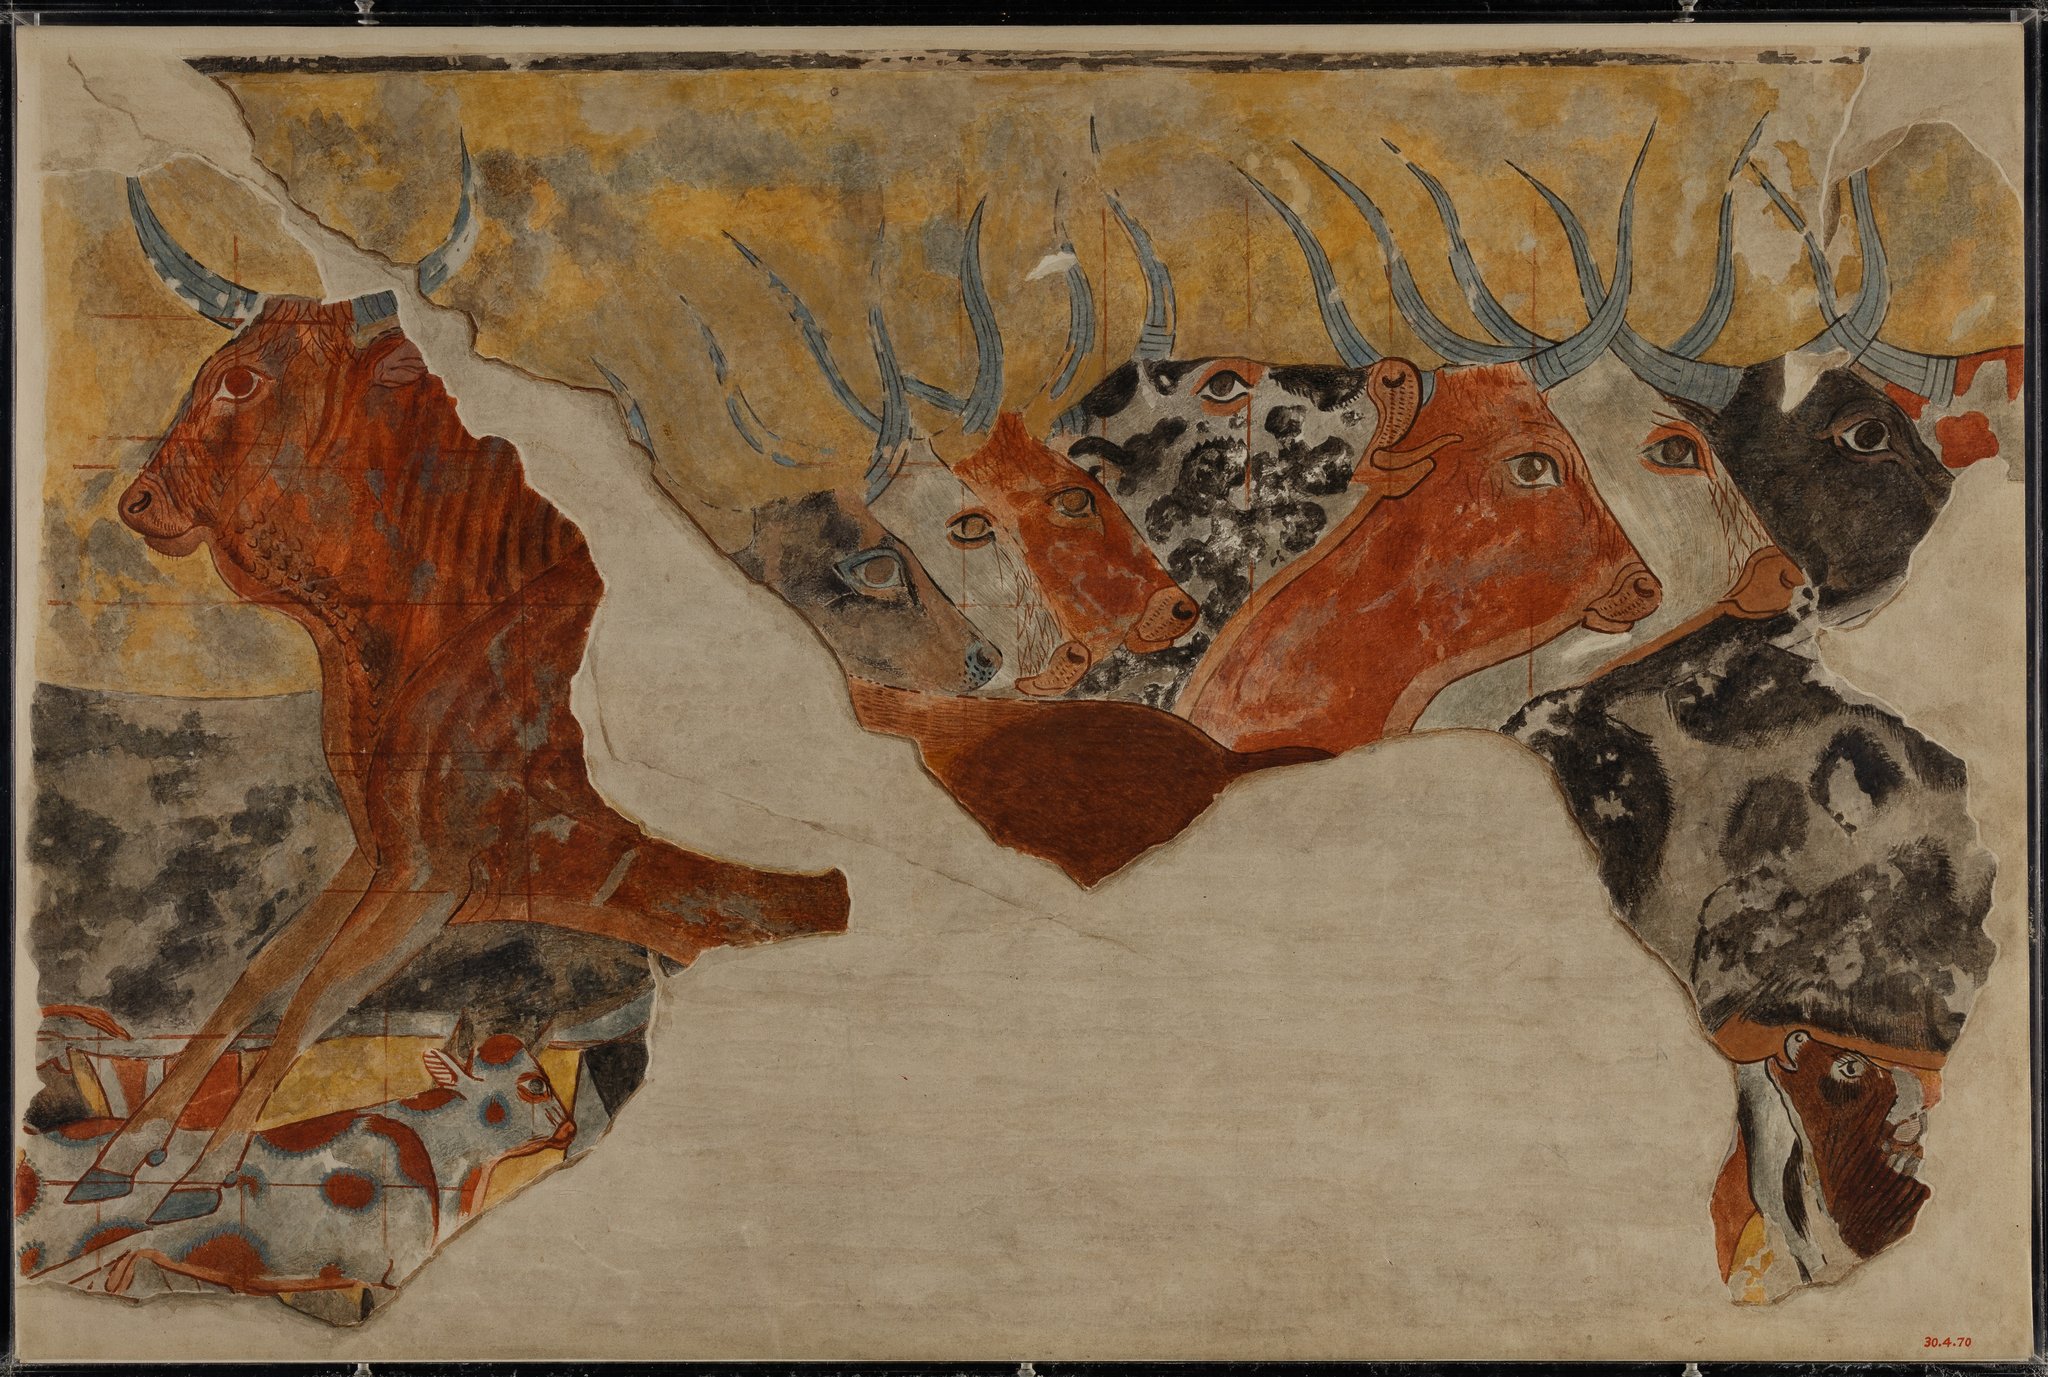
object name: facsimile, qenamun tt 93, cattle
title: Cattle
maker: hugh r. hopgood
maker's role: artist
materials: paper, paint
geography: egypt